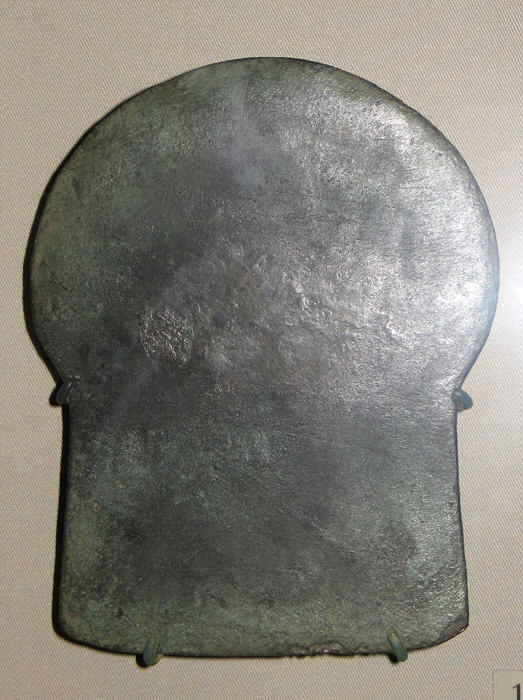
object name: ax blade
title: Anthropomorphic Celt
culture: indian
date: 1500-500 BCE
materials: copper